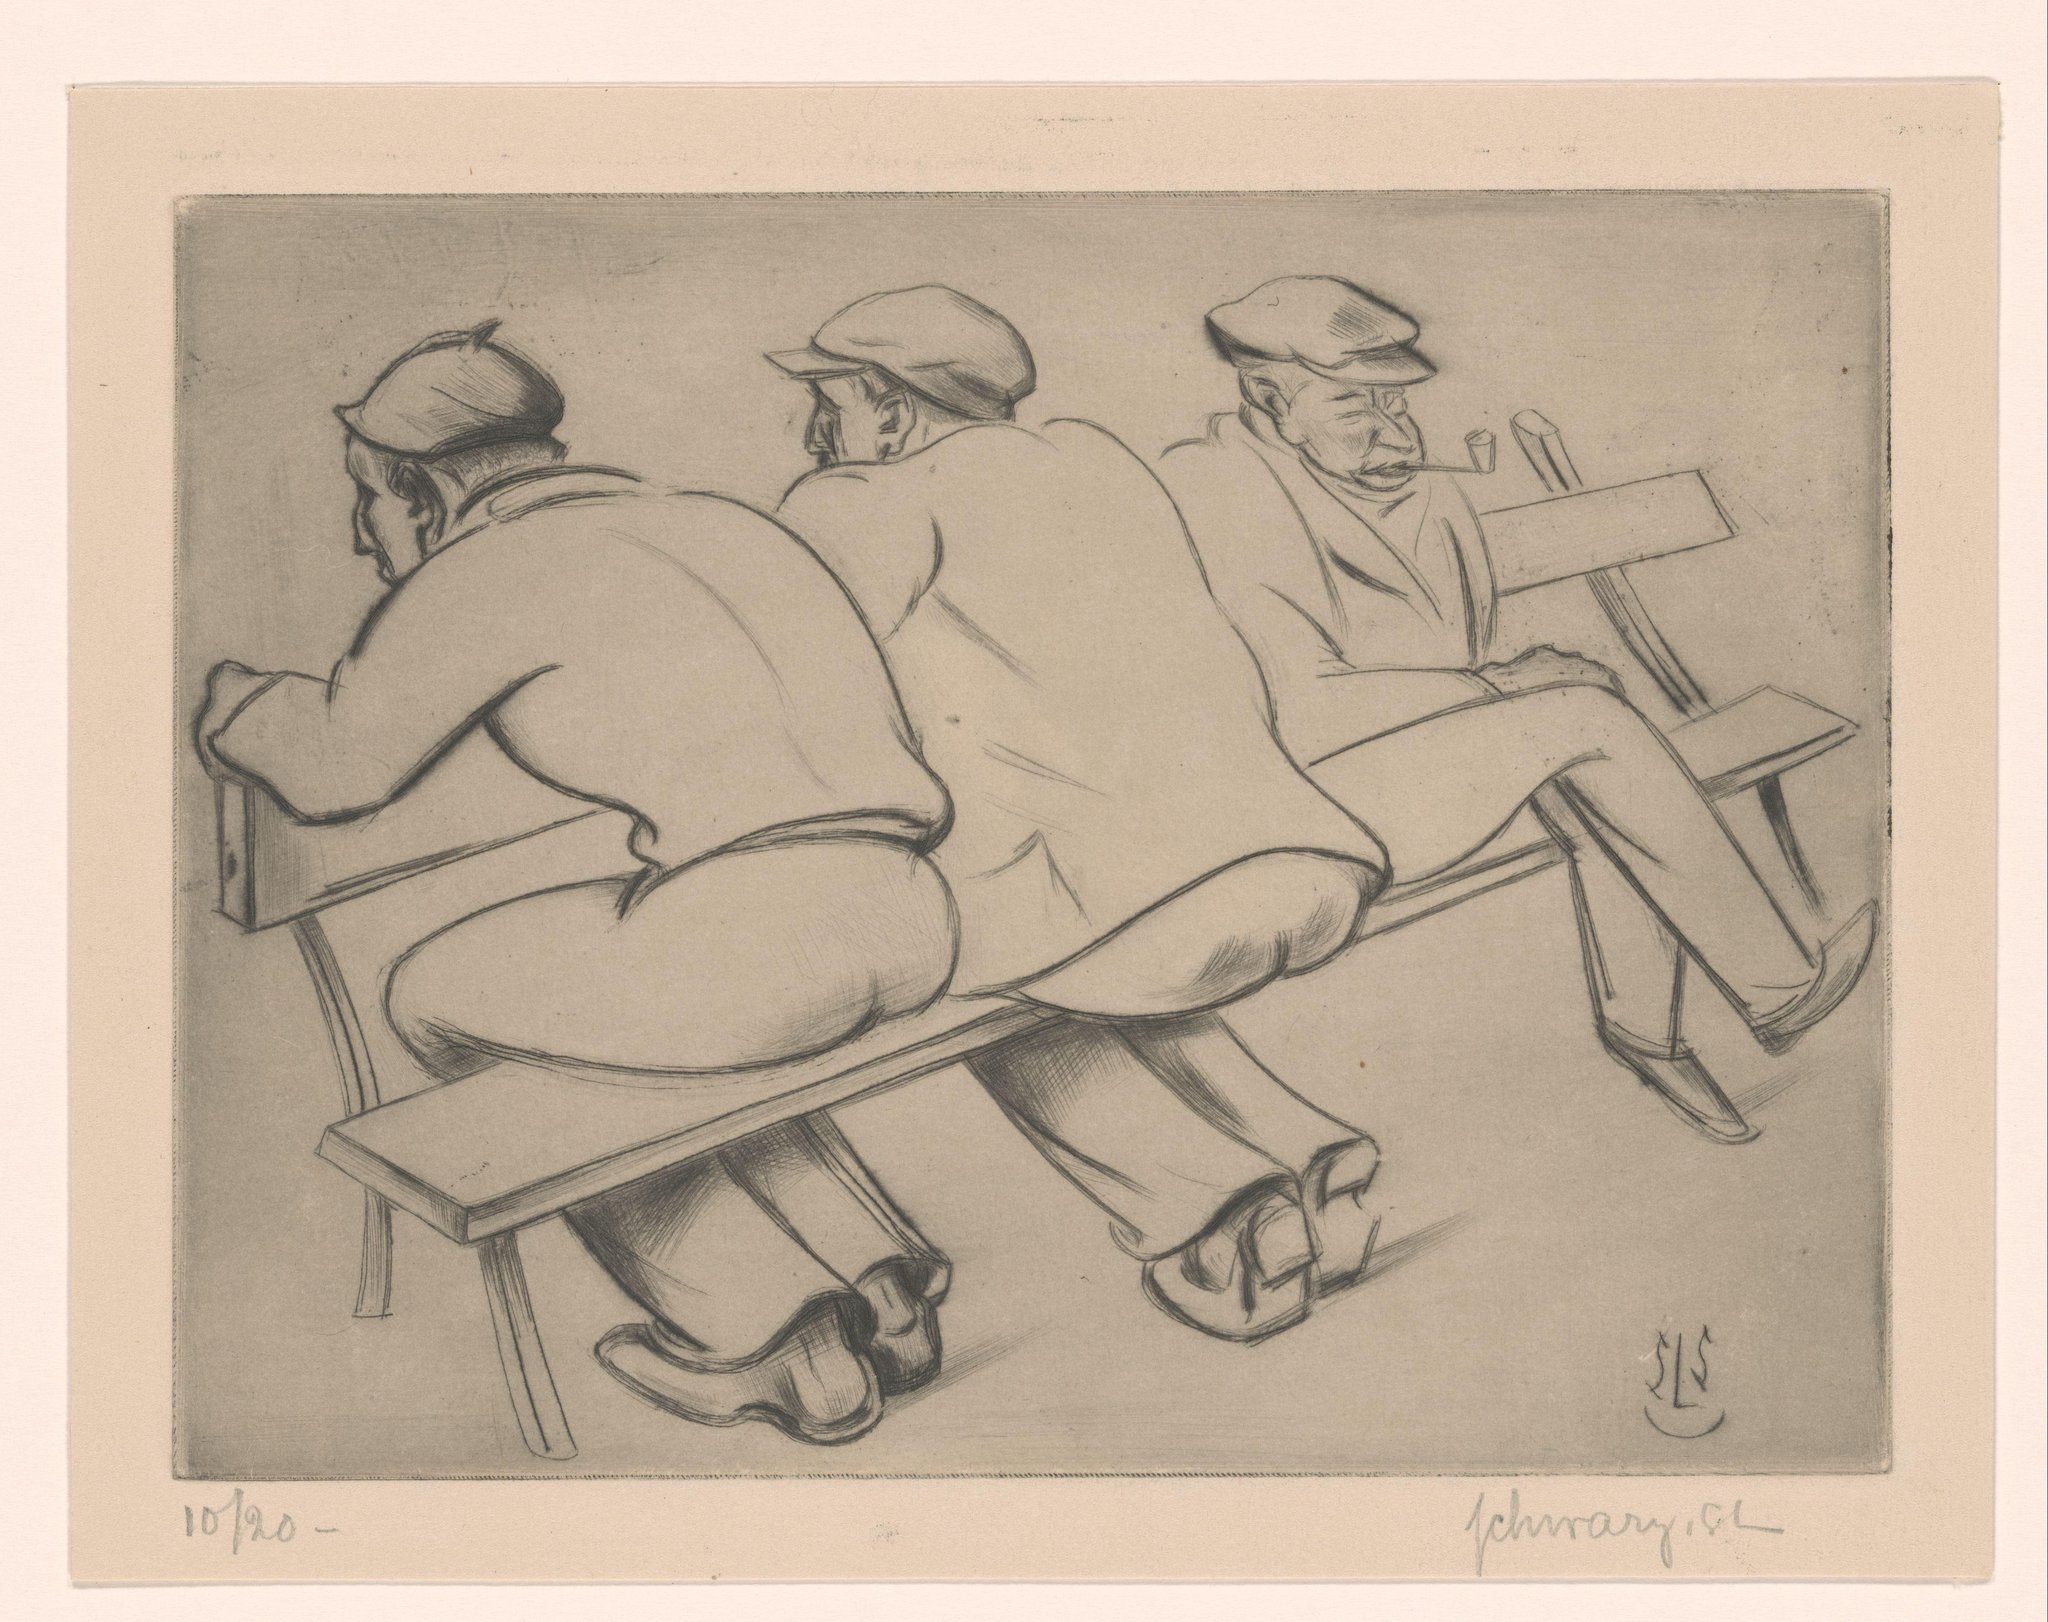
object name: print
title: Drie mannen op een bank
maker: mommie schwarz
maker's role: print maker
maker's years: 1876-1942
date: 1886-1931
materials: paper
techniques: drypoint, intaglio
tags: bench, sitting on an elevation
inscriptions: collector's mark: Lugt 2228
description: Twee mannen zitten achterstevoren op de bank. De derde man zit een pijp te roken.